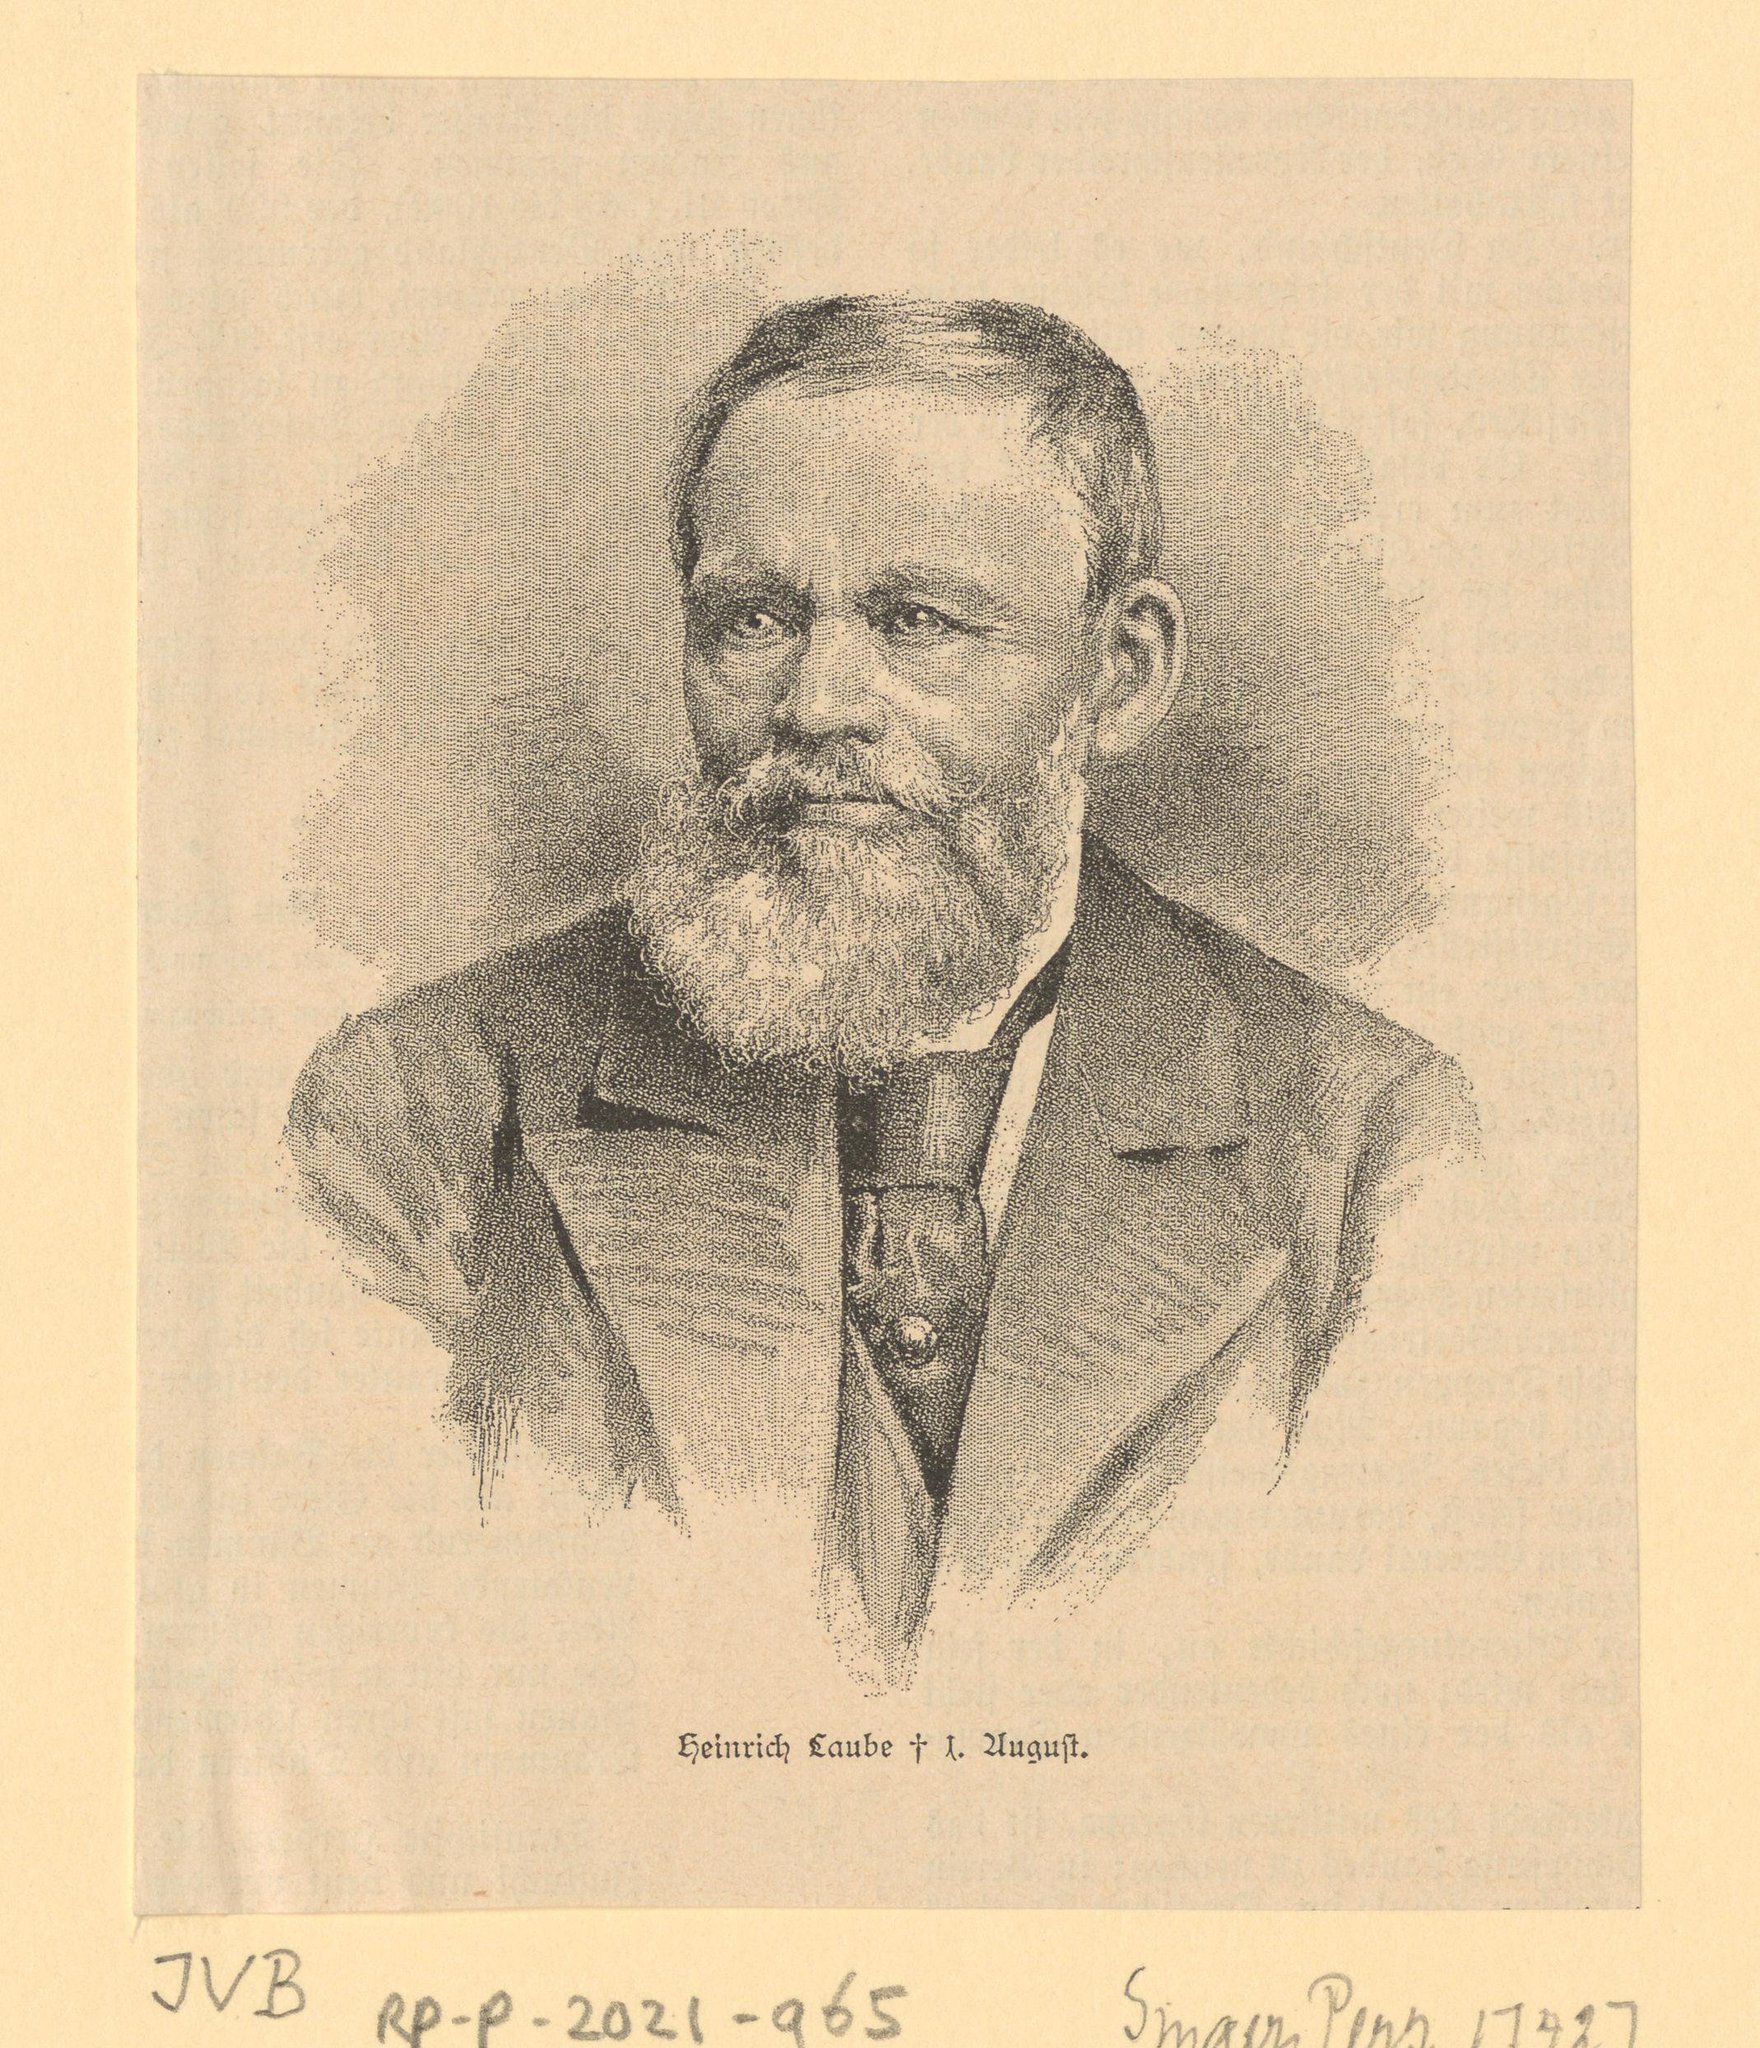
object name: photomechanical print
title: Portret van Heinrich Laube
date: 1884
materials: paper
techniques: letterpress printing, line block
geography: germany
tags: vienna, historical persons, portrait of a writer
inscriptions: stamp: ‘JVB’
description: Prent uit: Schorers Familienblatt 5 (1884), nr. 48, p. 768.